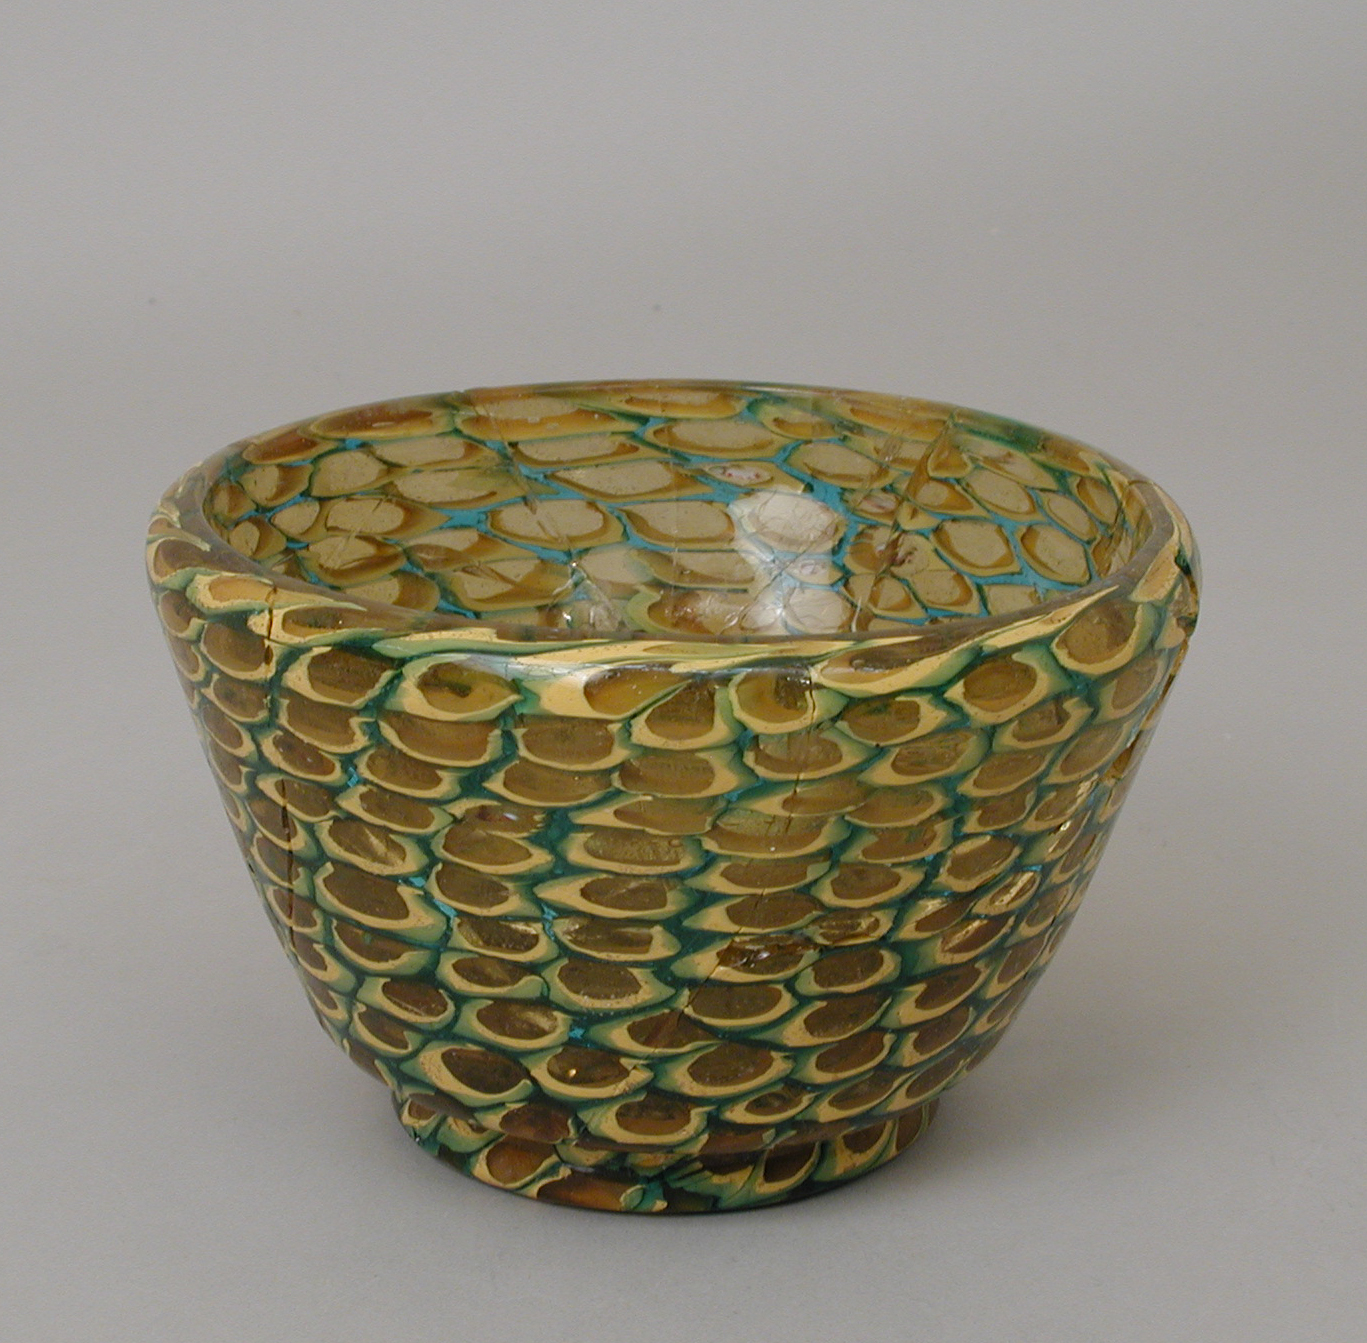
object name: bowl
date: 1870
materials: glass